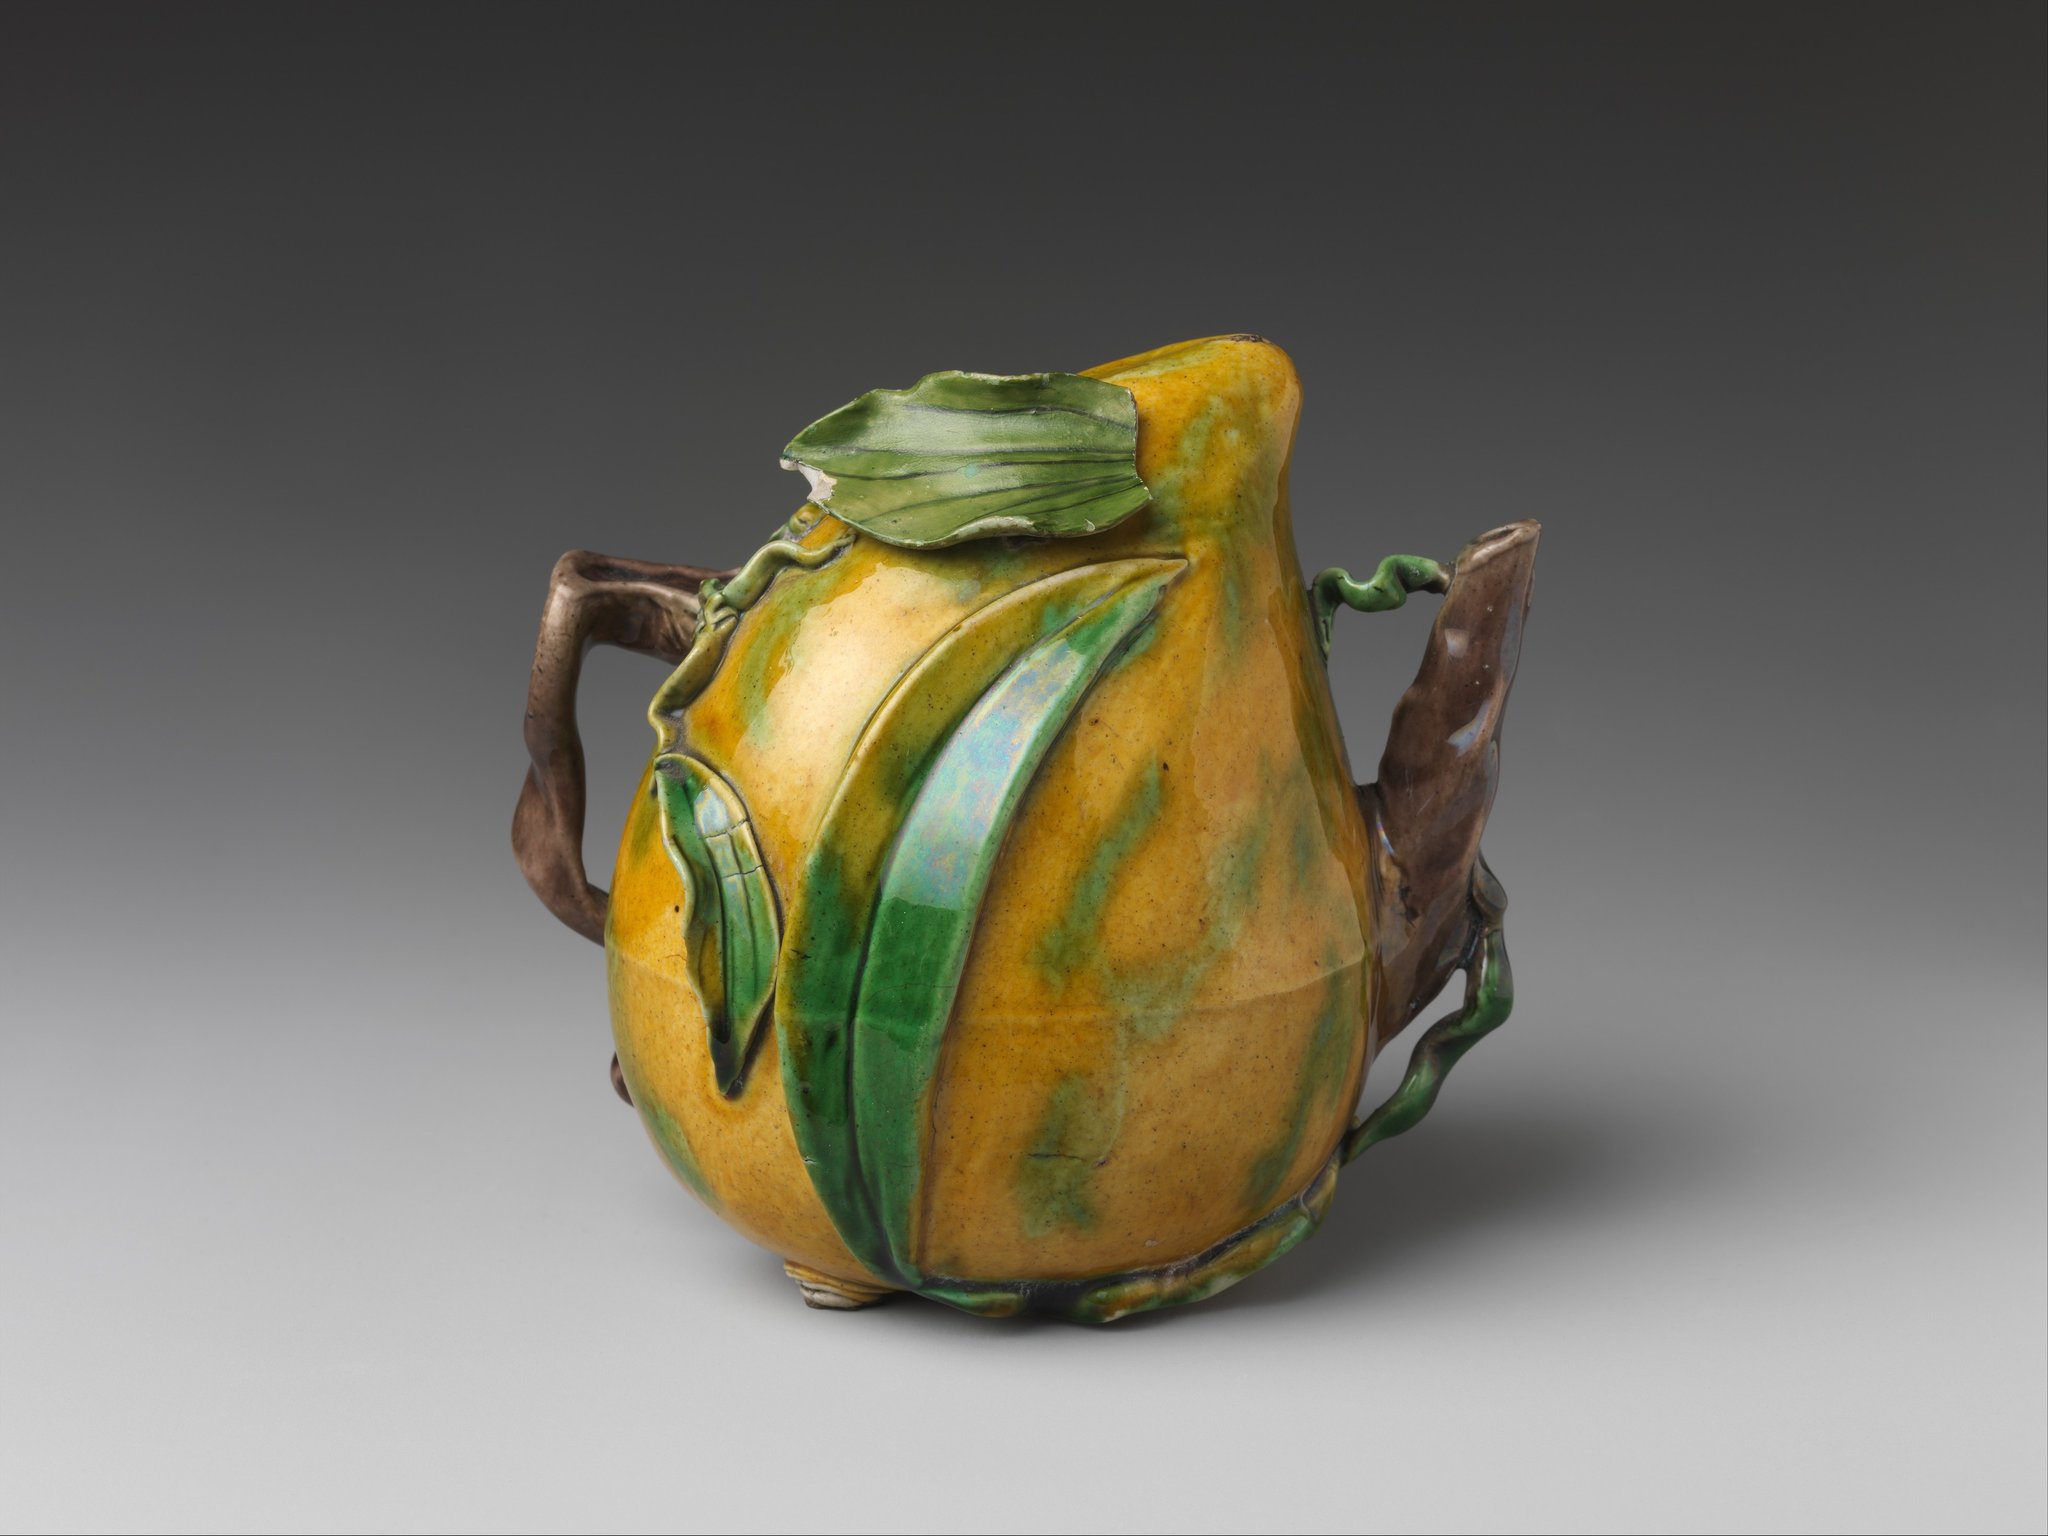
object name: ewer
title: Ewer in the shape of a peach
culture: chinese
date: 1801-1900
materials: glaze, porcelain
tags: peaches